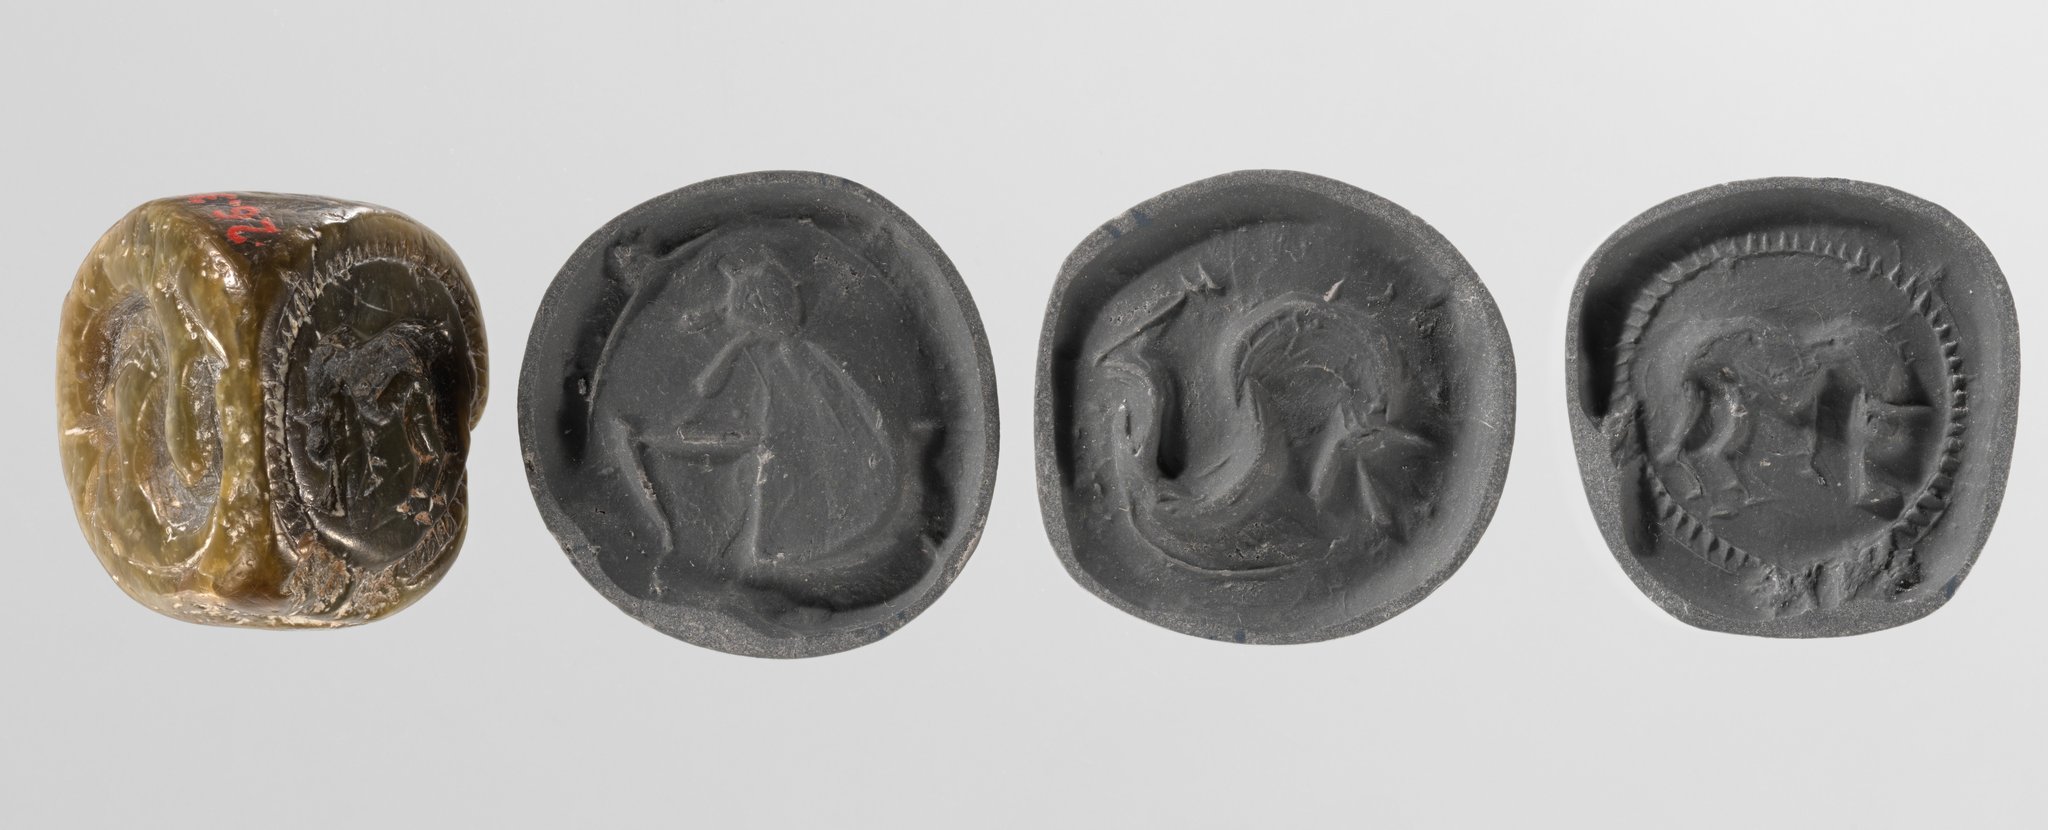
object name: prism, triangular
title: Steatite Triangular Prism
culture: minoan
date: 1800-1700 BCE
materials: stone